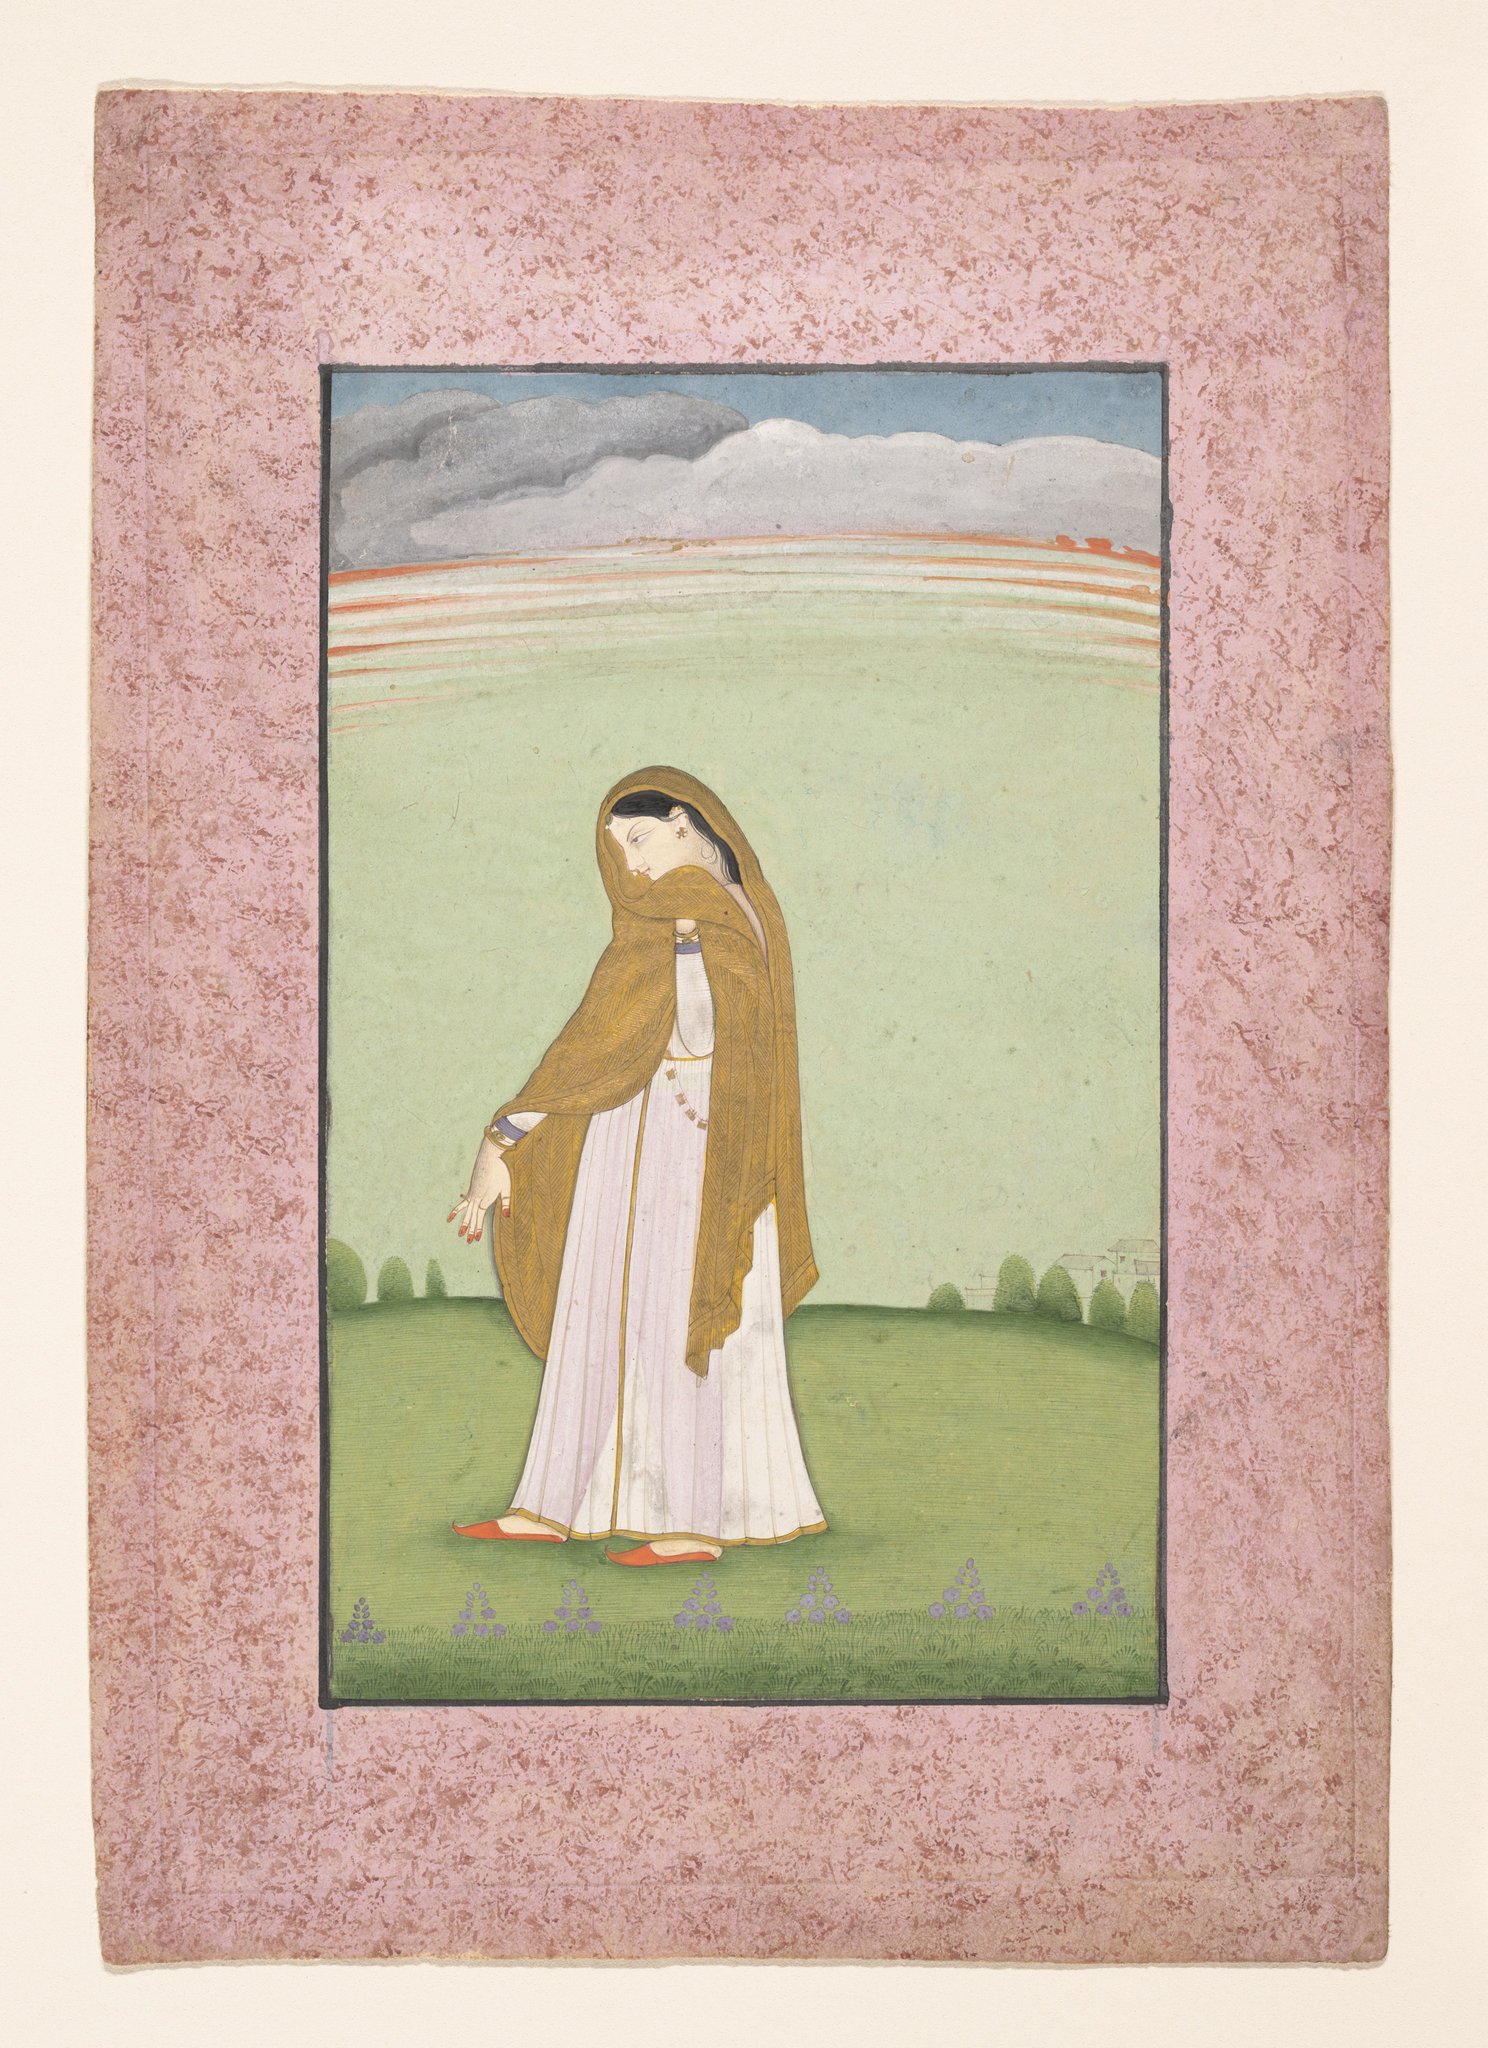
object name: painting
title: Abhisarika Nayika, a Heroine Longing for Her Lover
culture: indian, kangra, punjab hills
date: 1790-1800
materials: gold, ink, paper, watercolor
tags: women